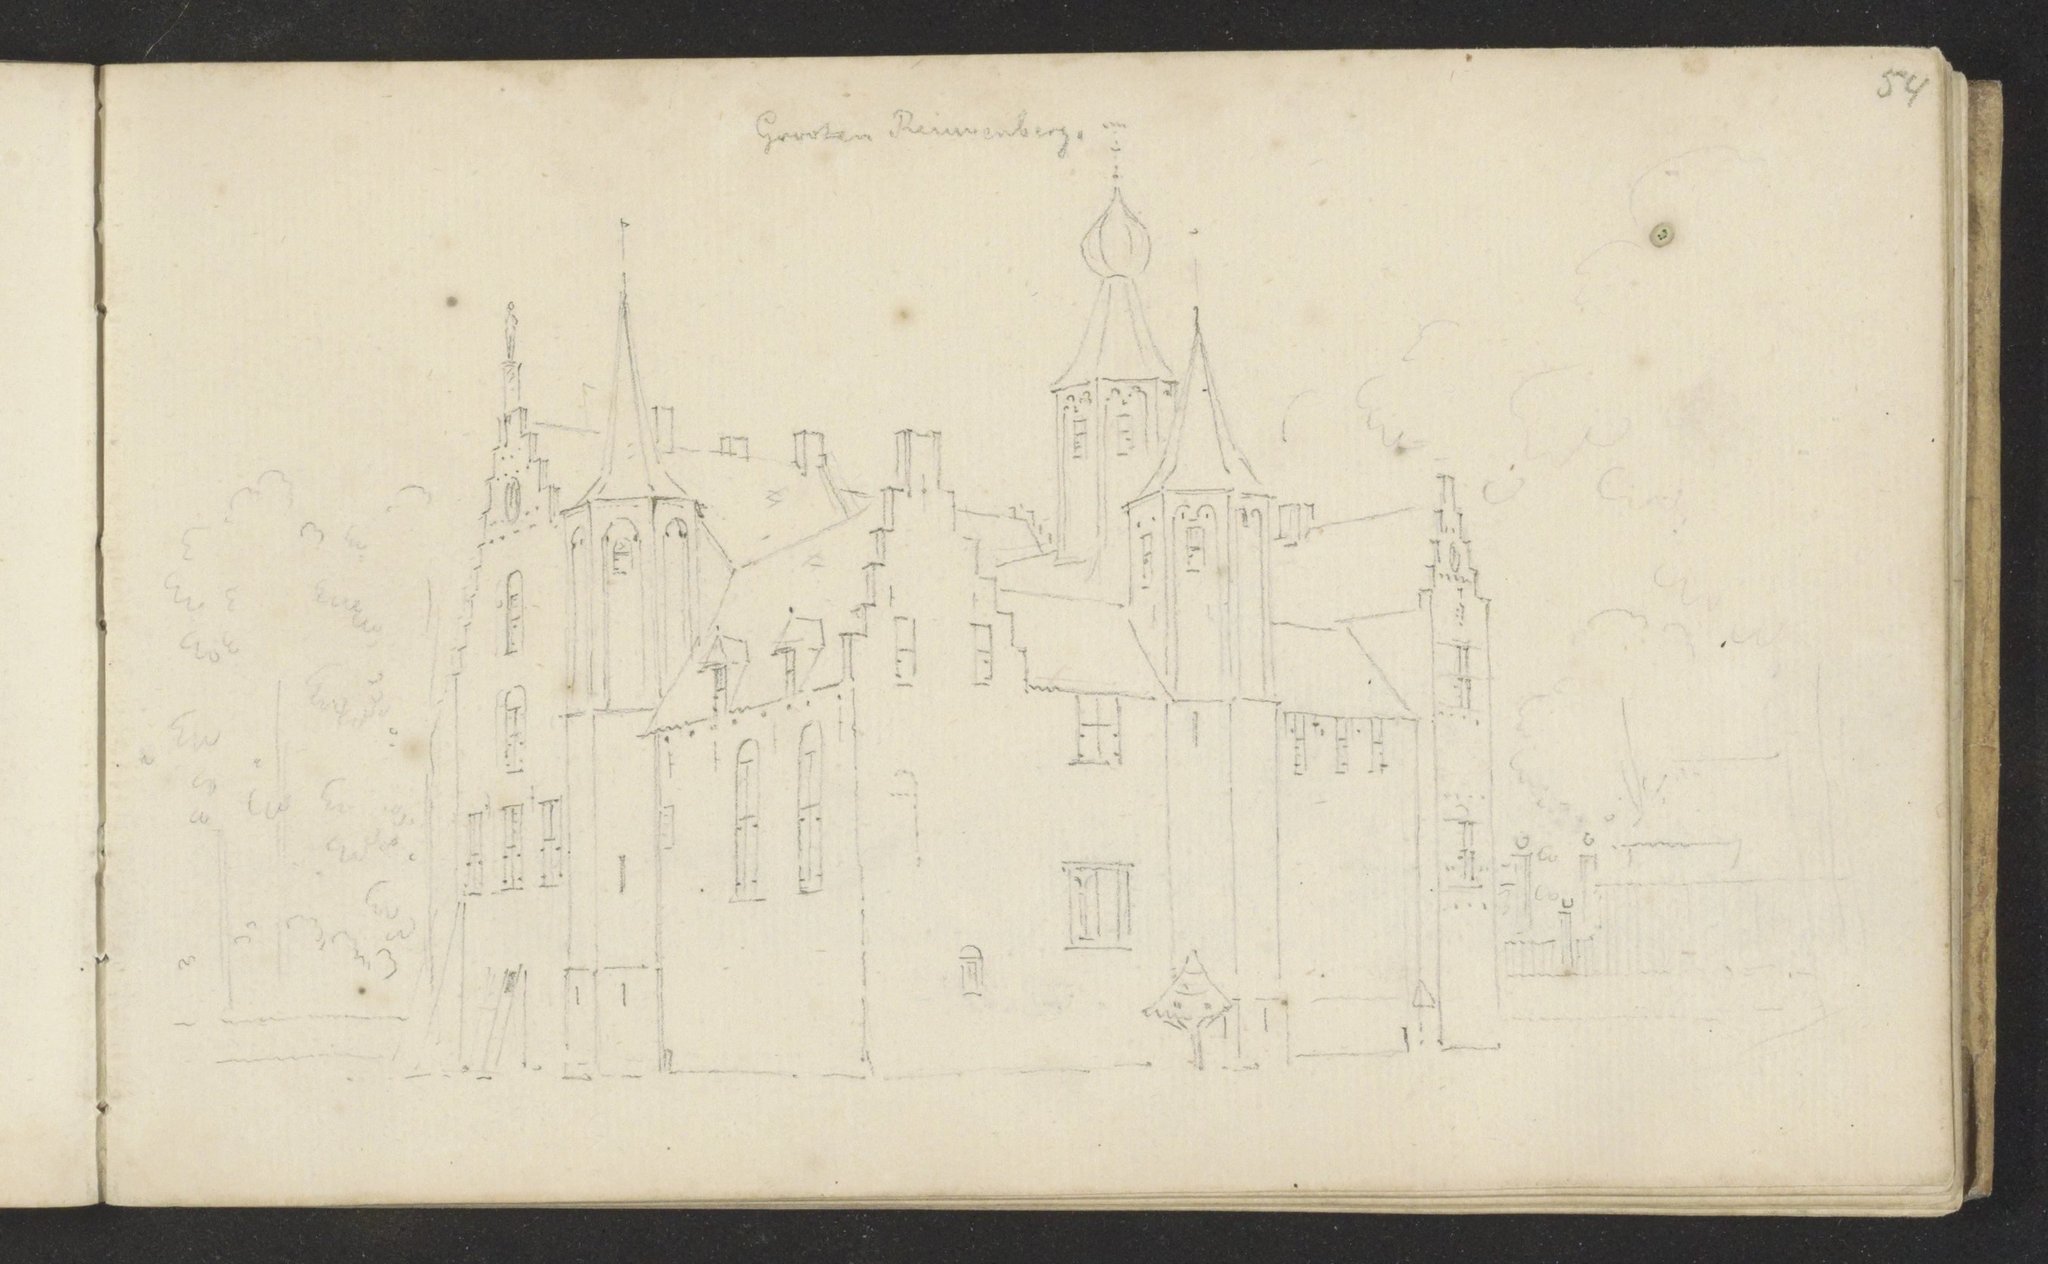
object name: sketchbook leaf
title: Kasteel Grote Ruwenberg bij Sint-Michielsgestel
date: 1701-1759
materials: paper, pencil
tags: castle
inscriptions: annotation: ‘Grooten Ruewenberg.’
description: Blad 54 recto uit een schetsboek met 65 bladen.